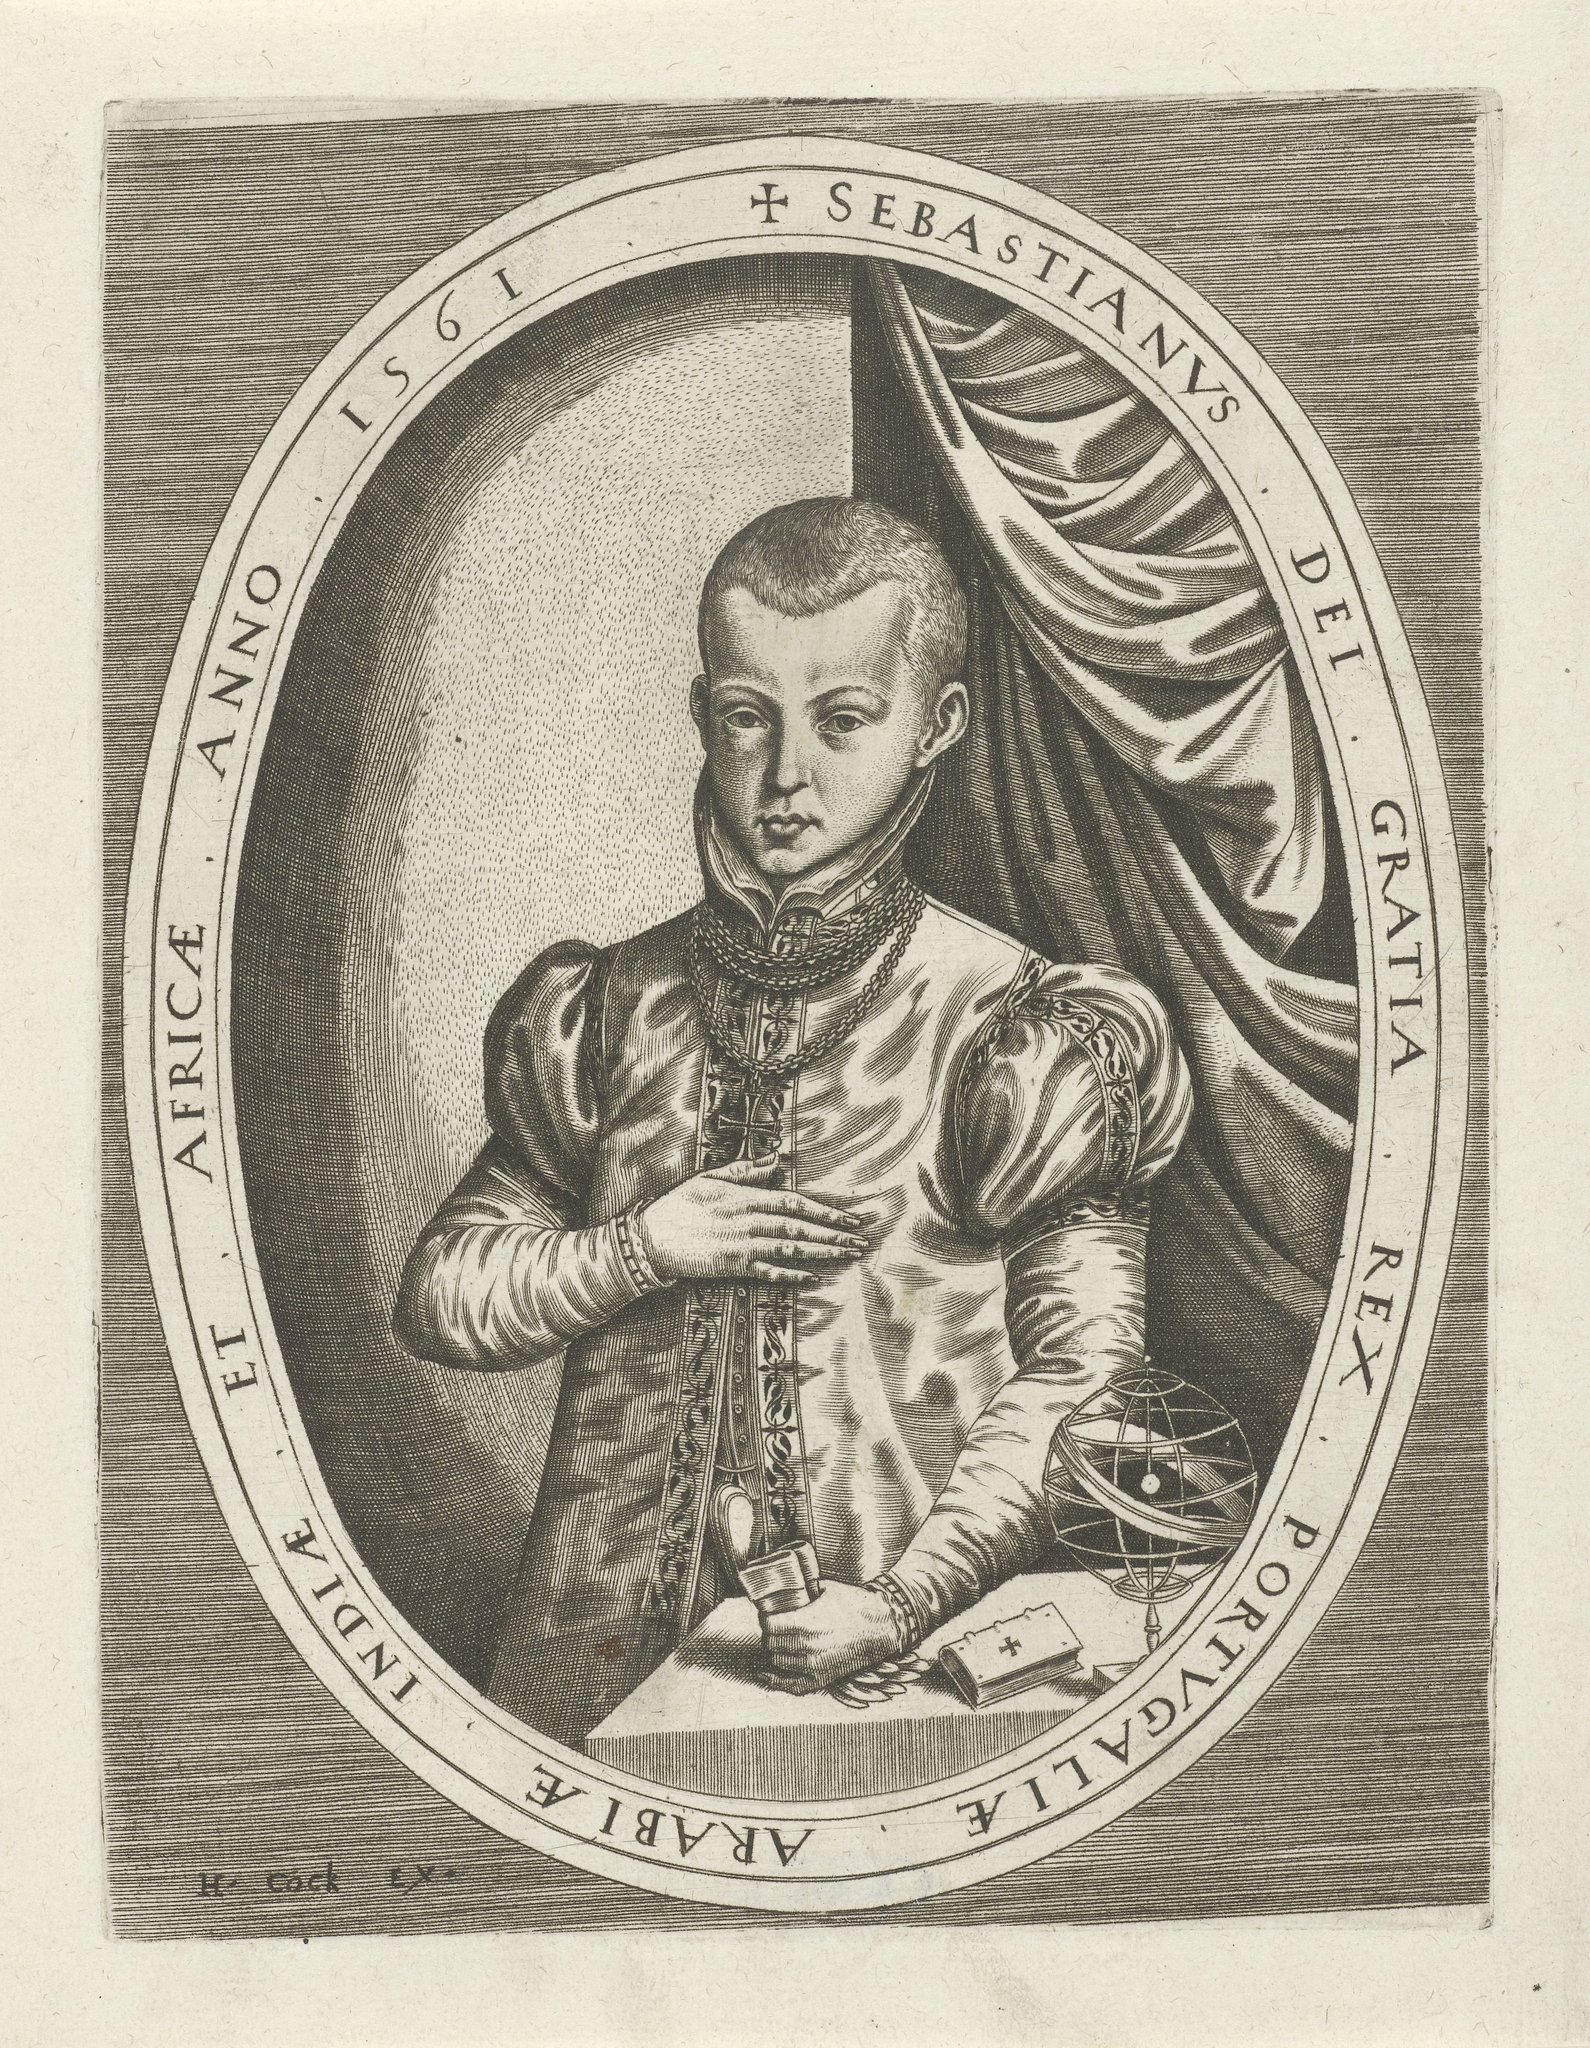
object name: print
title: Portret van Sebastiaan I van Portugal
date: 1561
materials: paper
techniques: engraving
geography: antwerp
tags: sebastiaan i van portugal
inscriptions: collector's mark: Lugt 2228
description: Portret van Sebastiaan I van Portugal ten halven lijve naar links bij een tafel. Op de tafel een bijbel en een armillarium. Buste in een ovale lijst met randschrift in het Latijn.